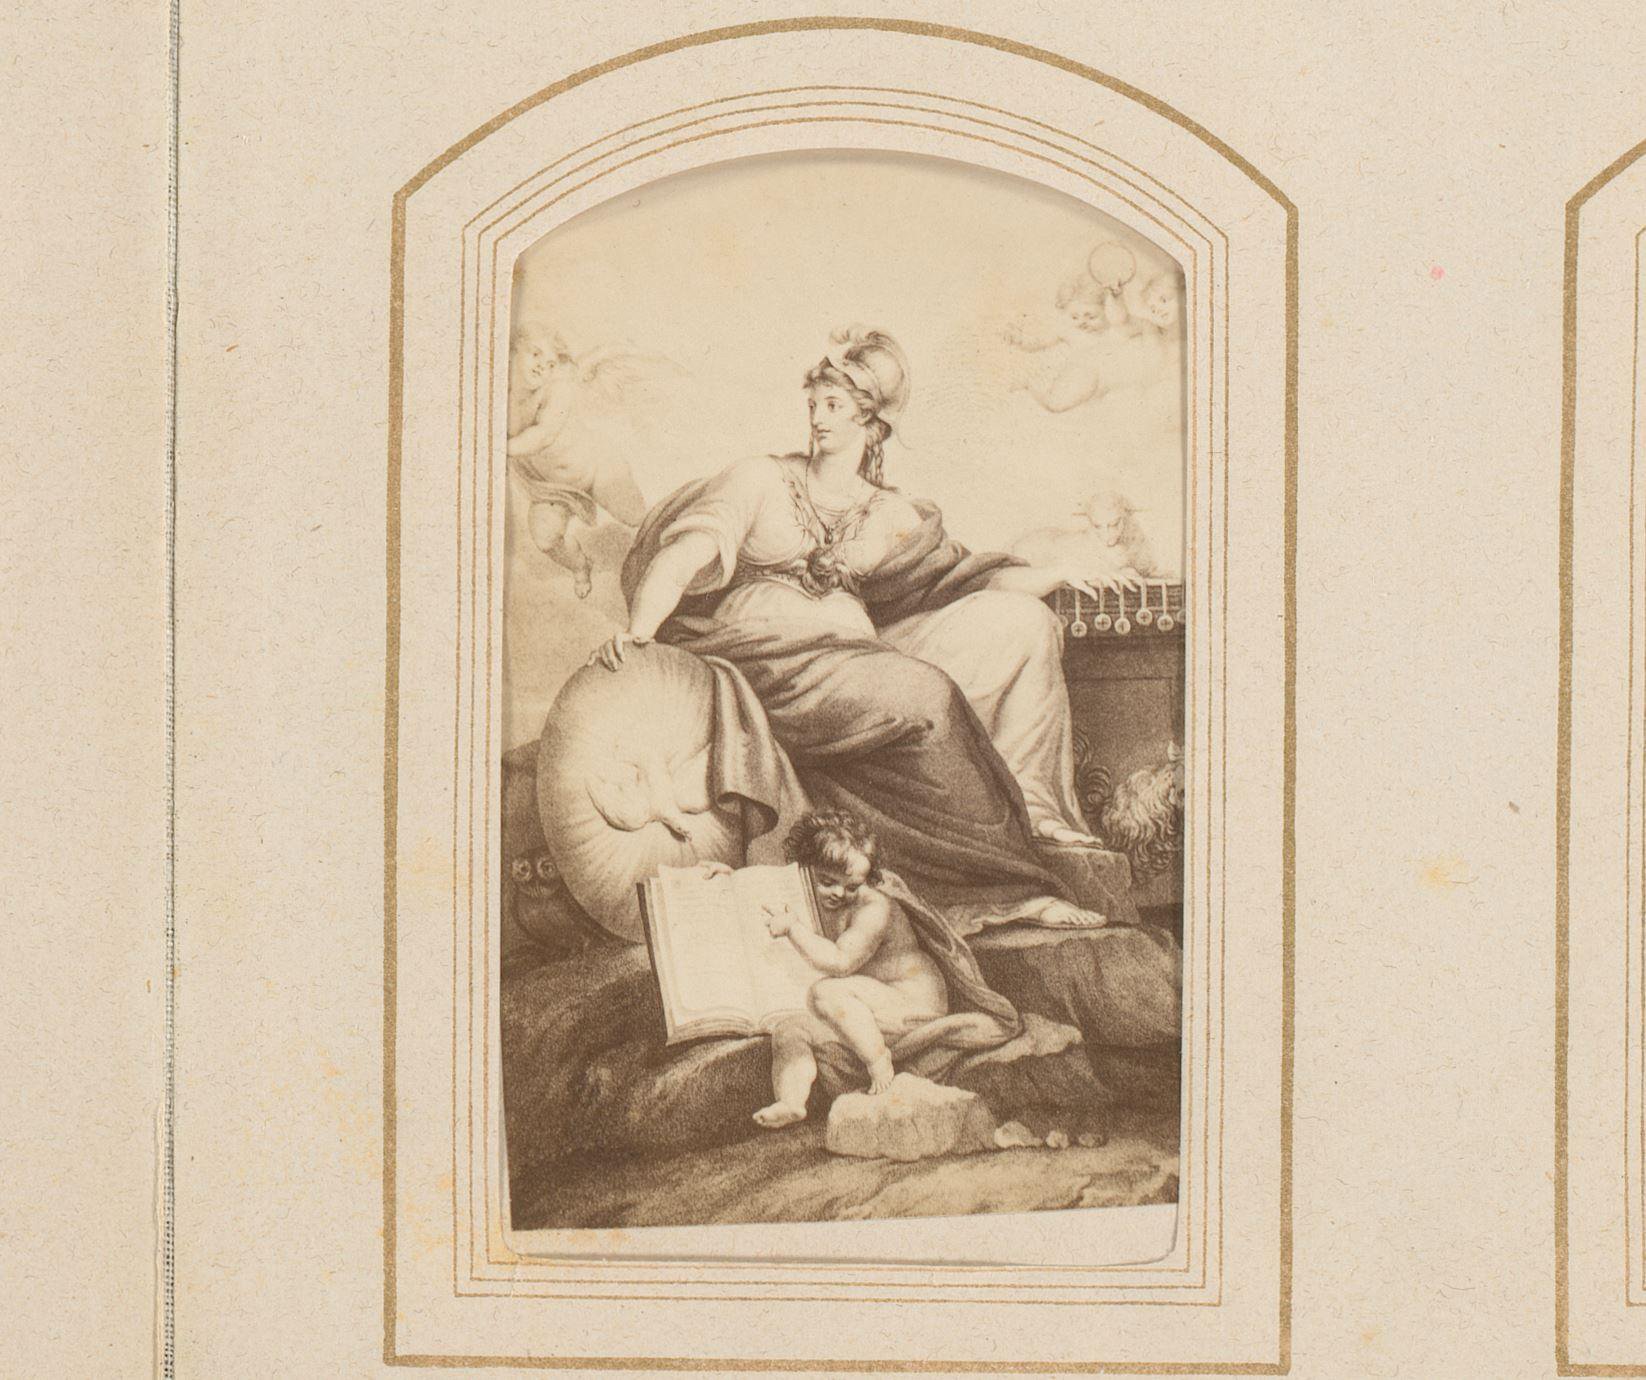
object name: reproduction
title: Fotoreproductie van Sagesse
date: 1870-1890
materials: cardboard, photographic support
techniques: albumen print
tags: wisdom; 'sapienza', 'sapienza humana', 'sapienza vera' (ripa), painting, drawing and the graphic arts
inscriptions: annotation: ‘Weisheit’, number: ‘1824’